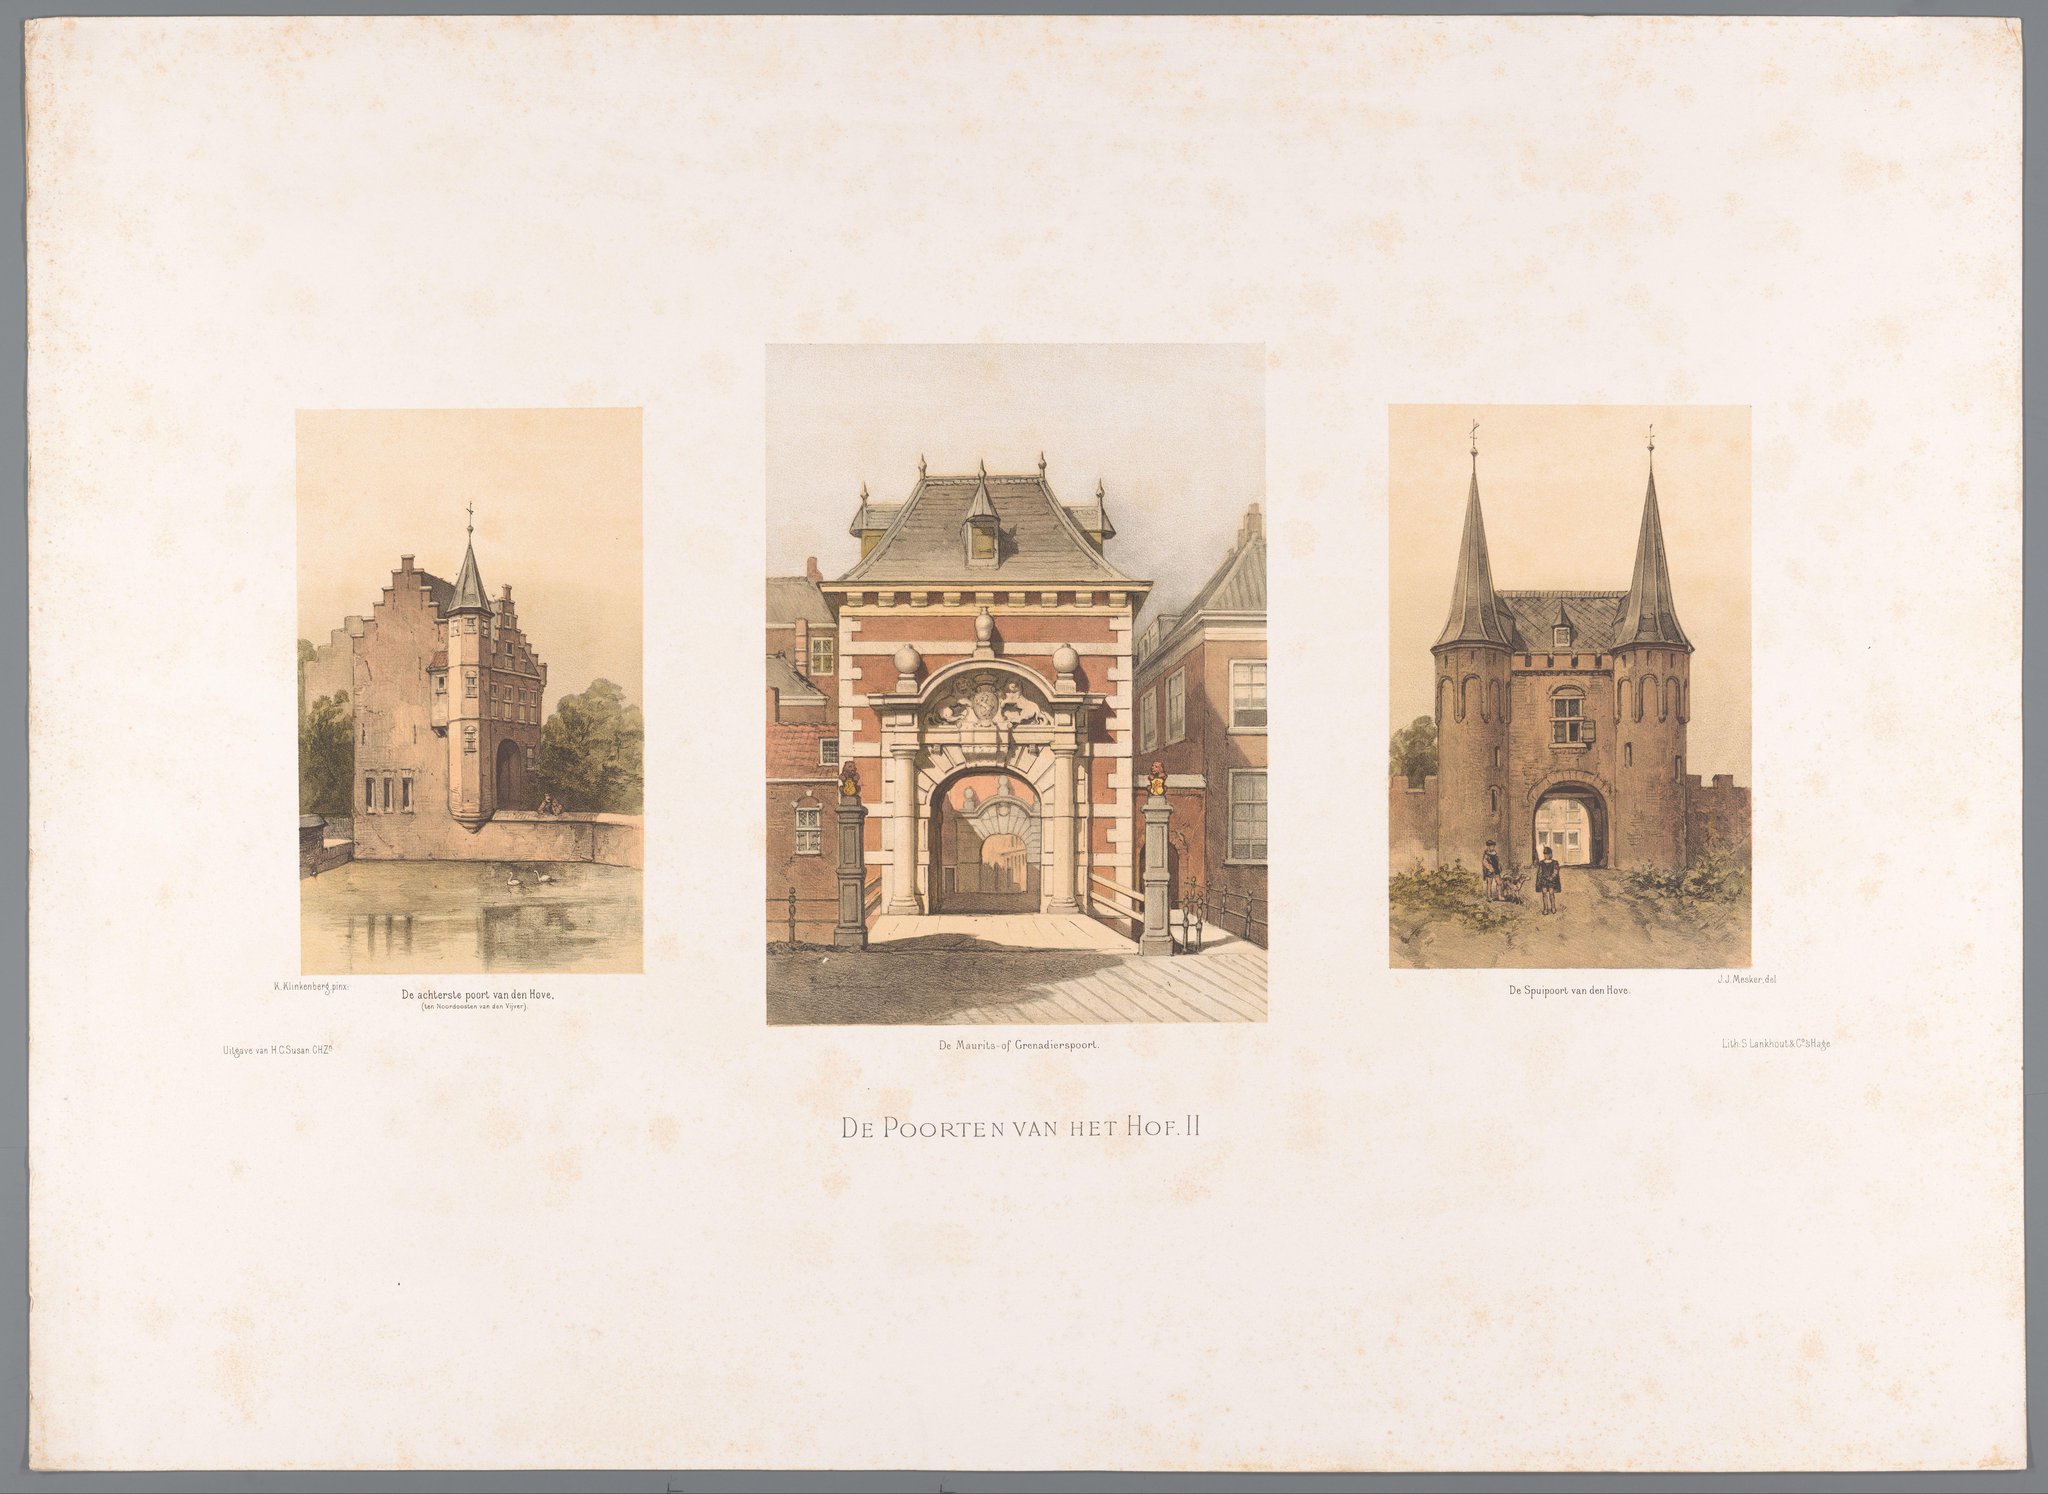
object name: print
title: Gezicht op verschillende poorten op en in de omgeving van het Binnenhof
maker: h.c. susan chzn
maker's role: publisher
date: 1879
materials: paper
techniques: lithograph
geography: the hague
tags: gate, entrance, national government